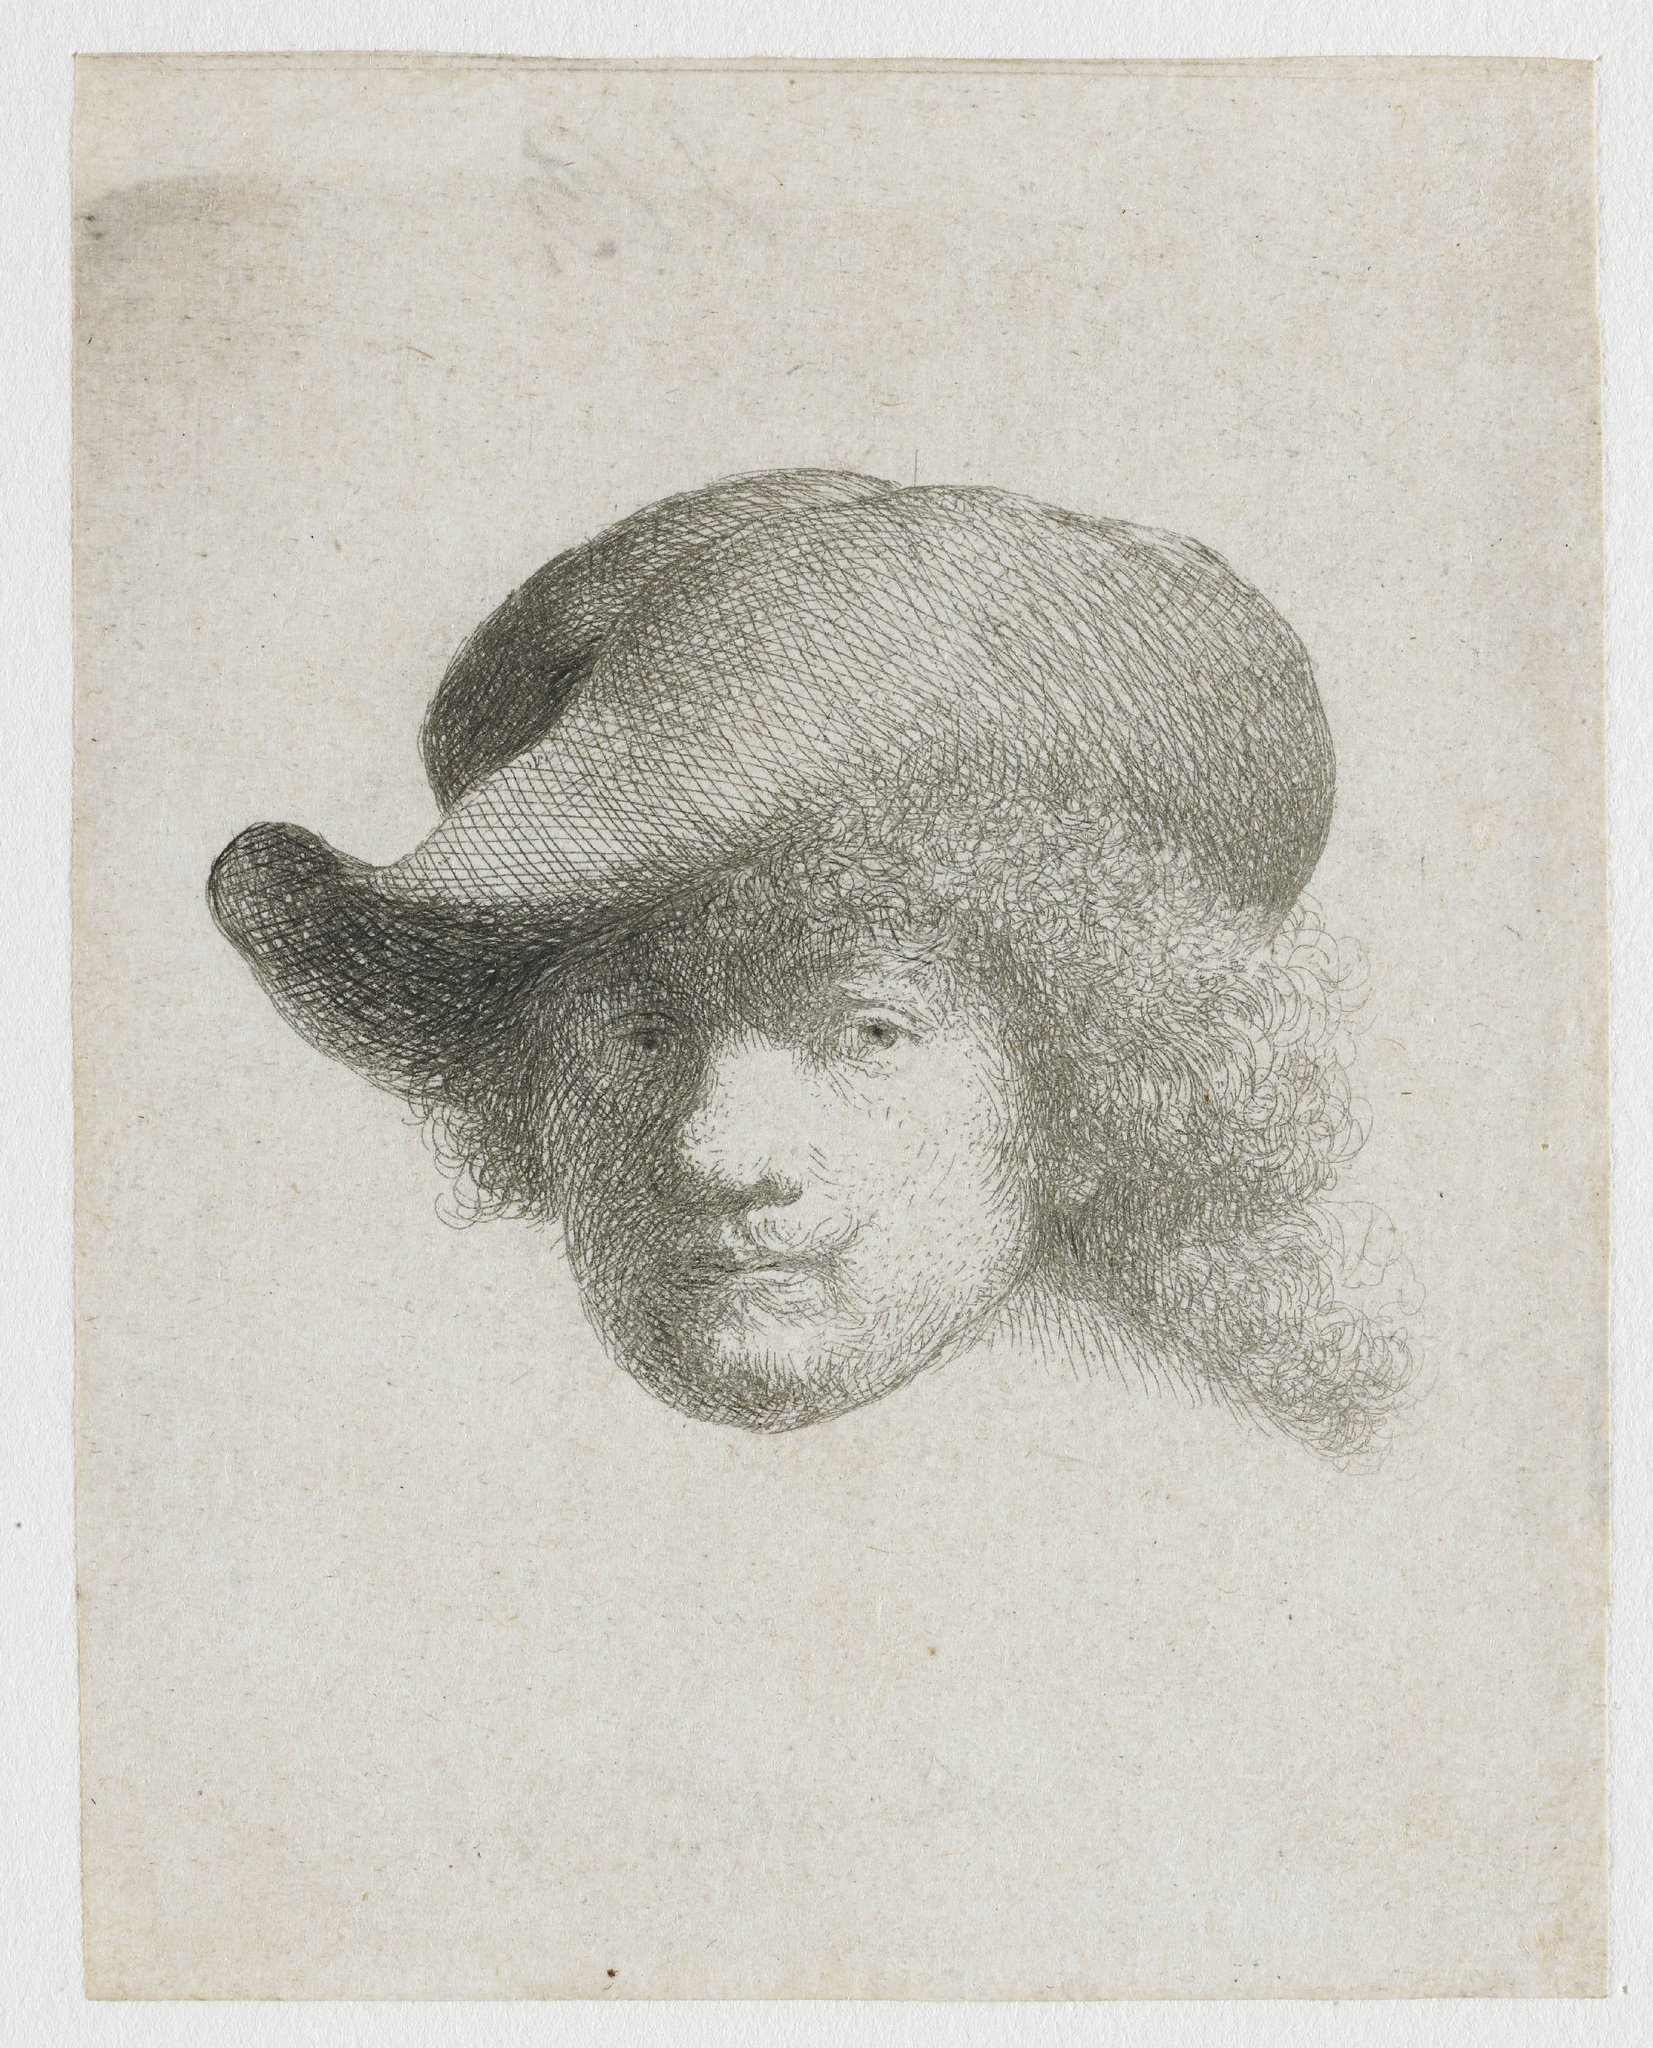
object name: print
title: Self-portrait in a soft hat and a patterned cloak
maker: rembrandt van rijn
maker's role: draughtsman, painter, print maker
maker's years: 1606-1669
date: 1631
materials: paper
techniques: etching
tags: leiden, amsterdam, painter, print maker, rembrandt van rijn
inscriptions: collector's mark: Lugt 2228, collector's mark: Lugt 1419, mark: ‘R. P. Carew 1835’, collector's mark: Lugt 2173